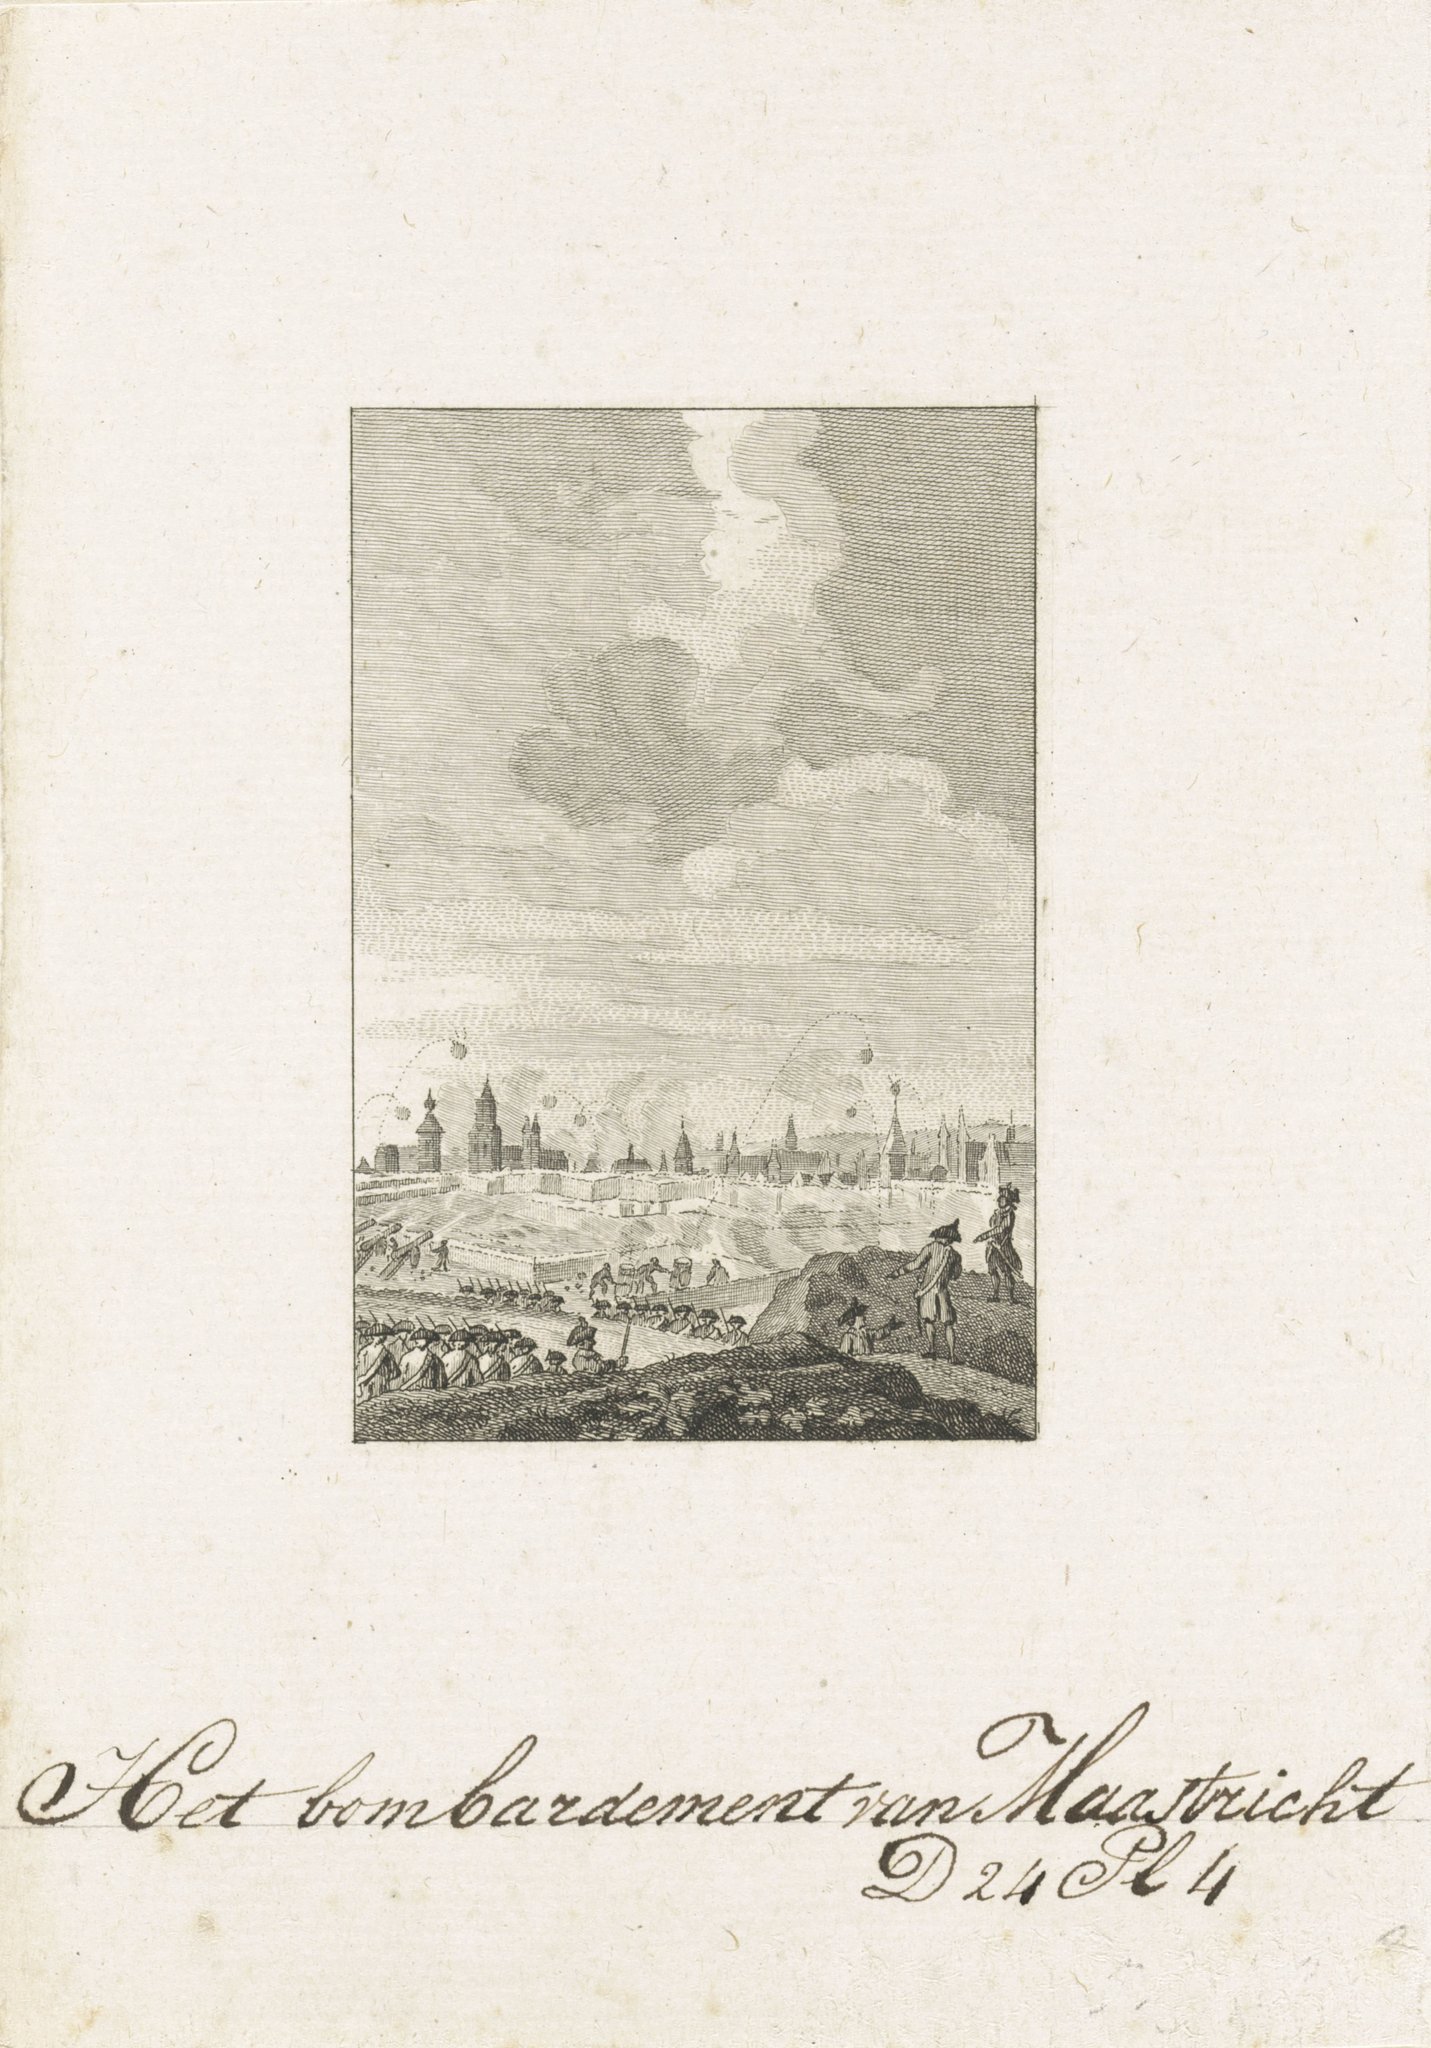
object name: print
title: Bombardement van Maastricht, 1793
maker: cornelis bogerts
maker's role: print maker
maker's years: 1745-1817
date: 1793-1795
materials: paper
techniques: engraving, etching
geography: northern netherlands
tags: bombardment ~ siege, maastricht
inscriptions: collector's mark: Lugt 2228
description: Gebruikt als illustratie in: J. Fokke, Geschiedenissen der Vereenigde Nederlanden voor de vaderlandsche jeugd, Johannes Allart, Amsterdam 1783-1795, 25 delen, dl. 24, pl. 4.